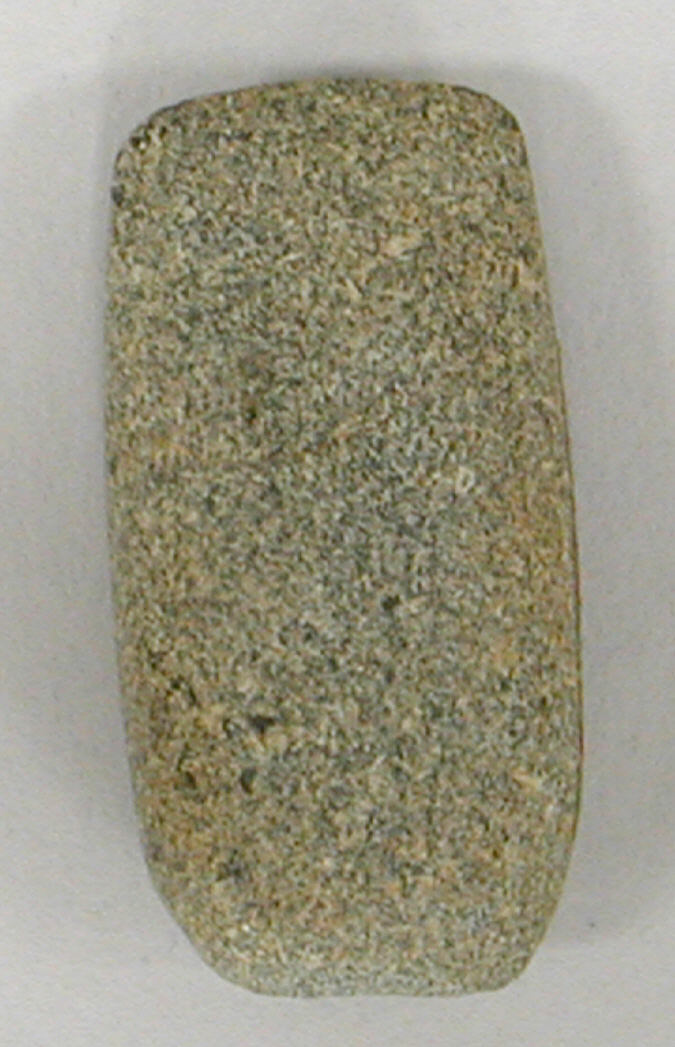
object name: chisel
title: Stone Chisel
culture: costa rican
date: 1501-1600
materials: stone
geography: costa rica